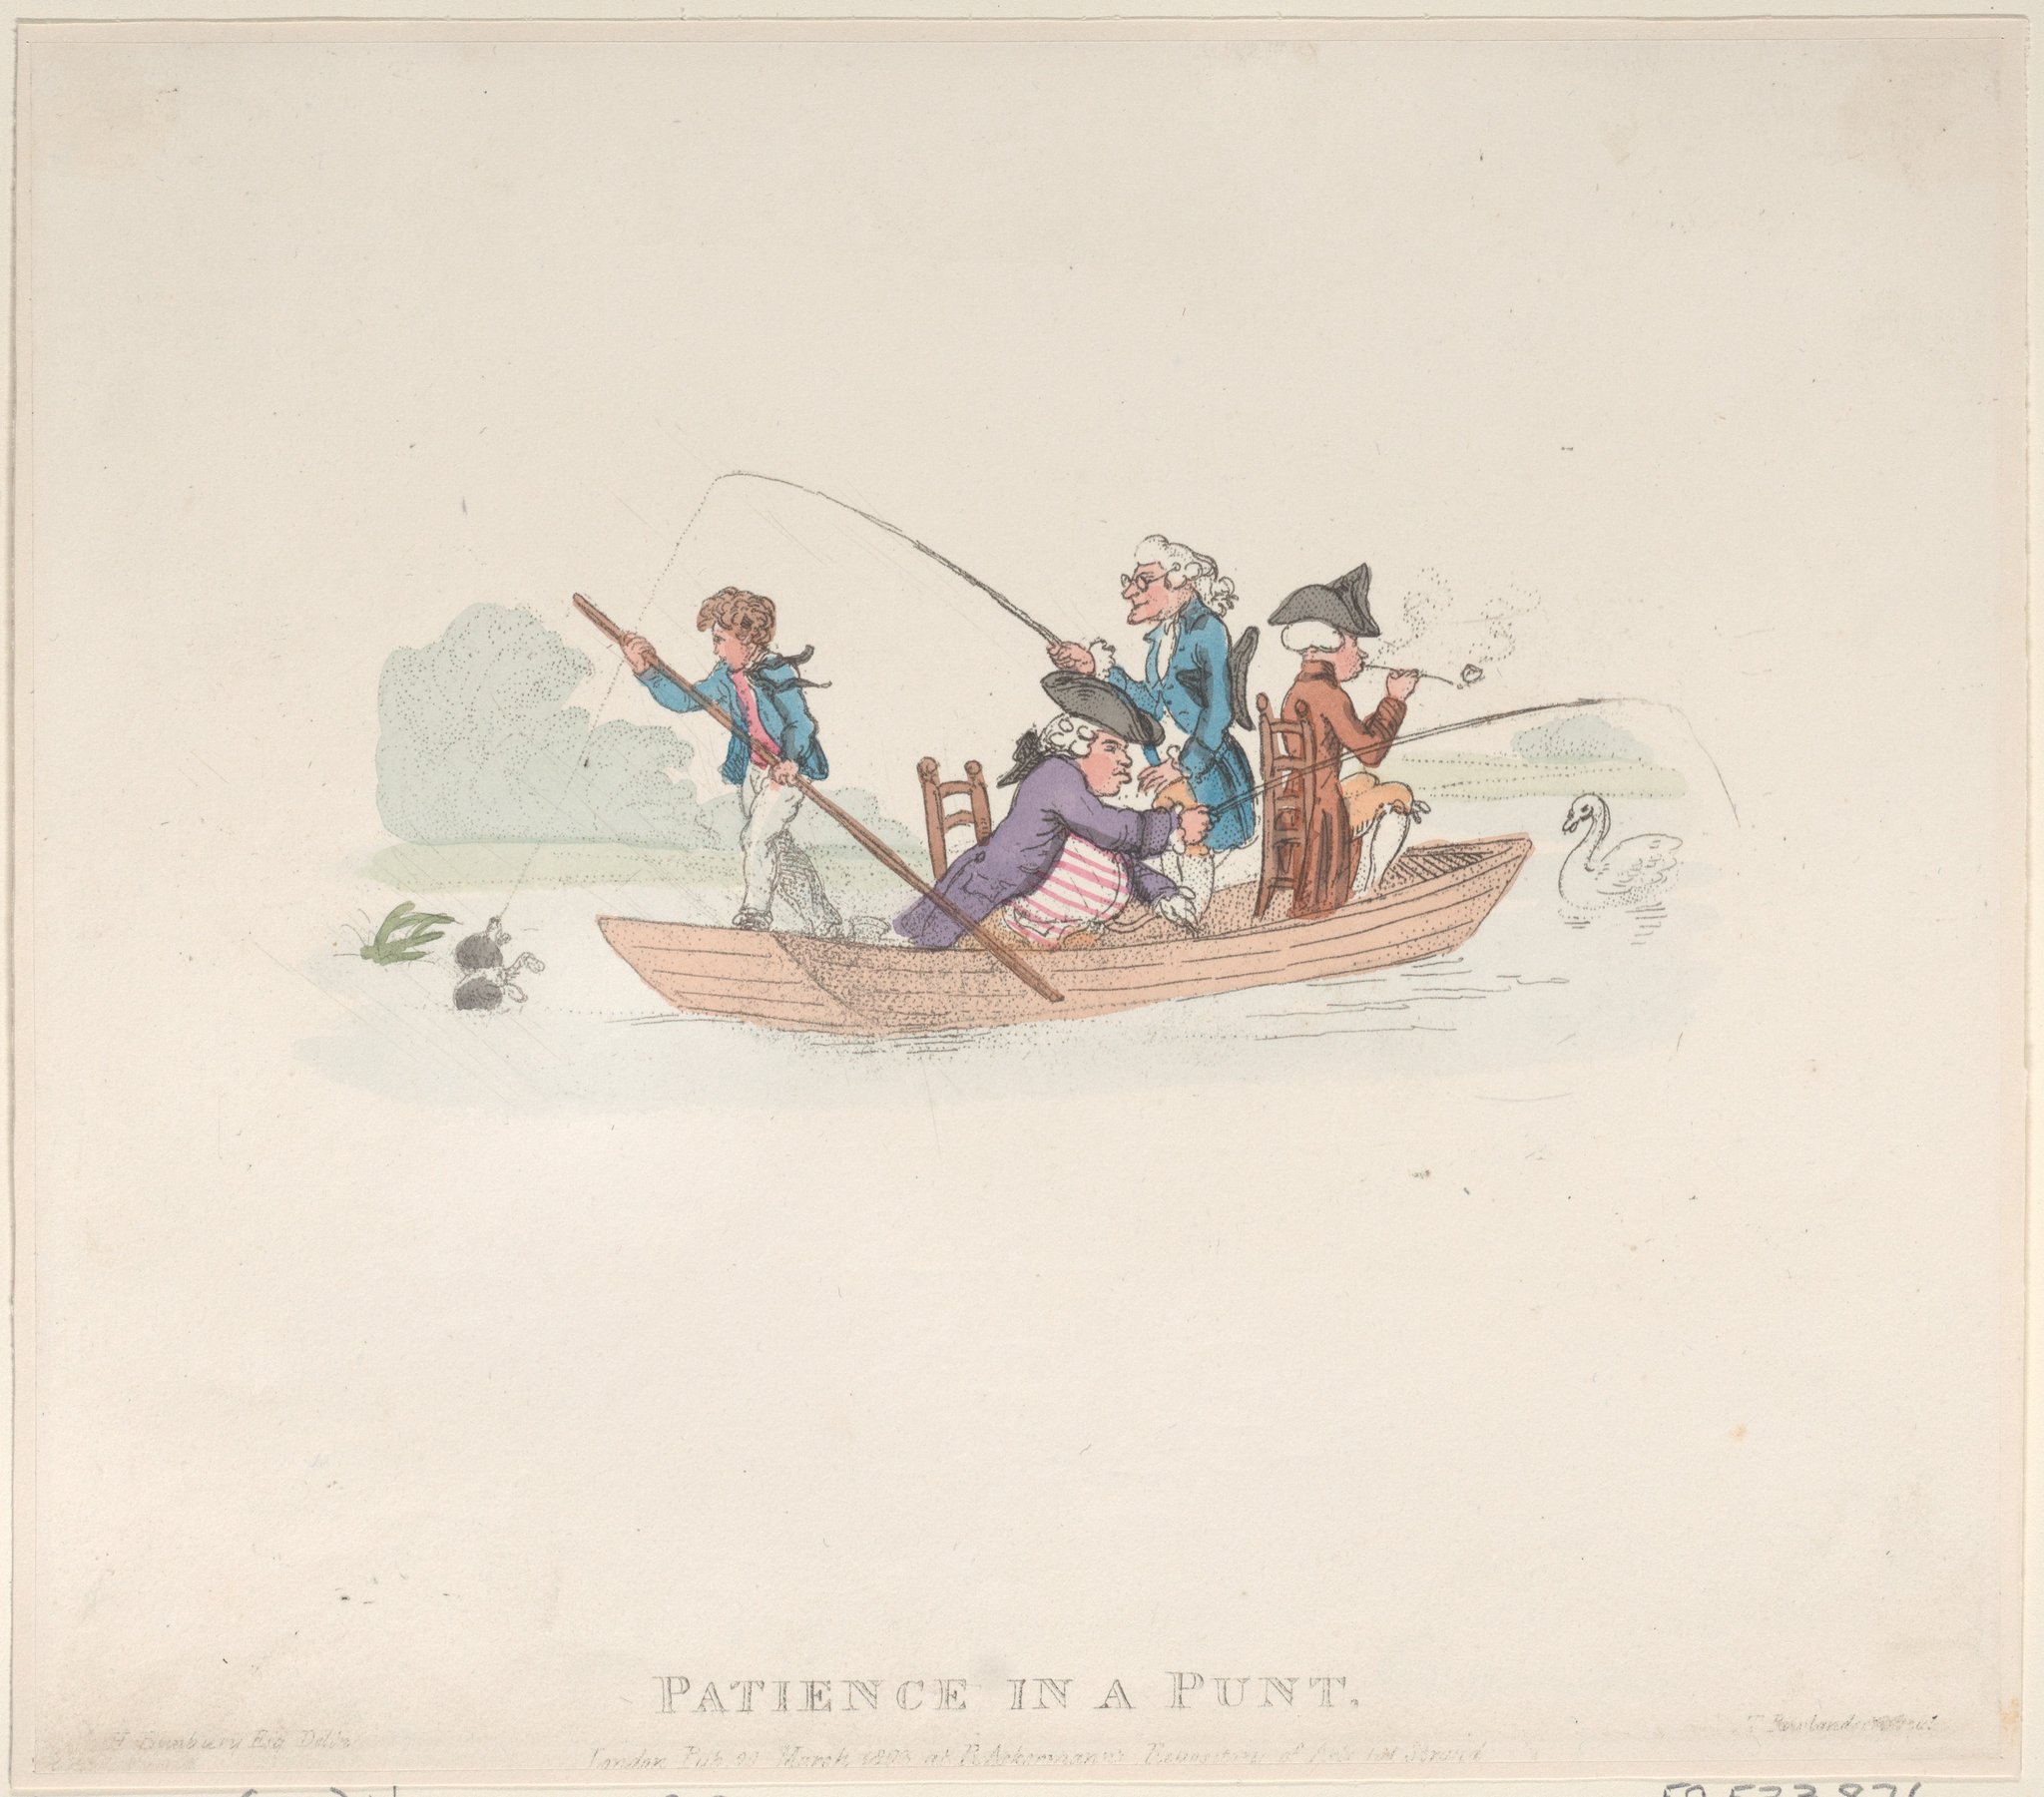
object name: print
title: Patience in a Punt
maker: thomas rowlandson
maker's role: artist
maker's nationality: british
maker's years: 1757-1827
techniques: etching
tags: satire,men,fishing,boats